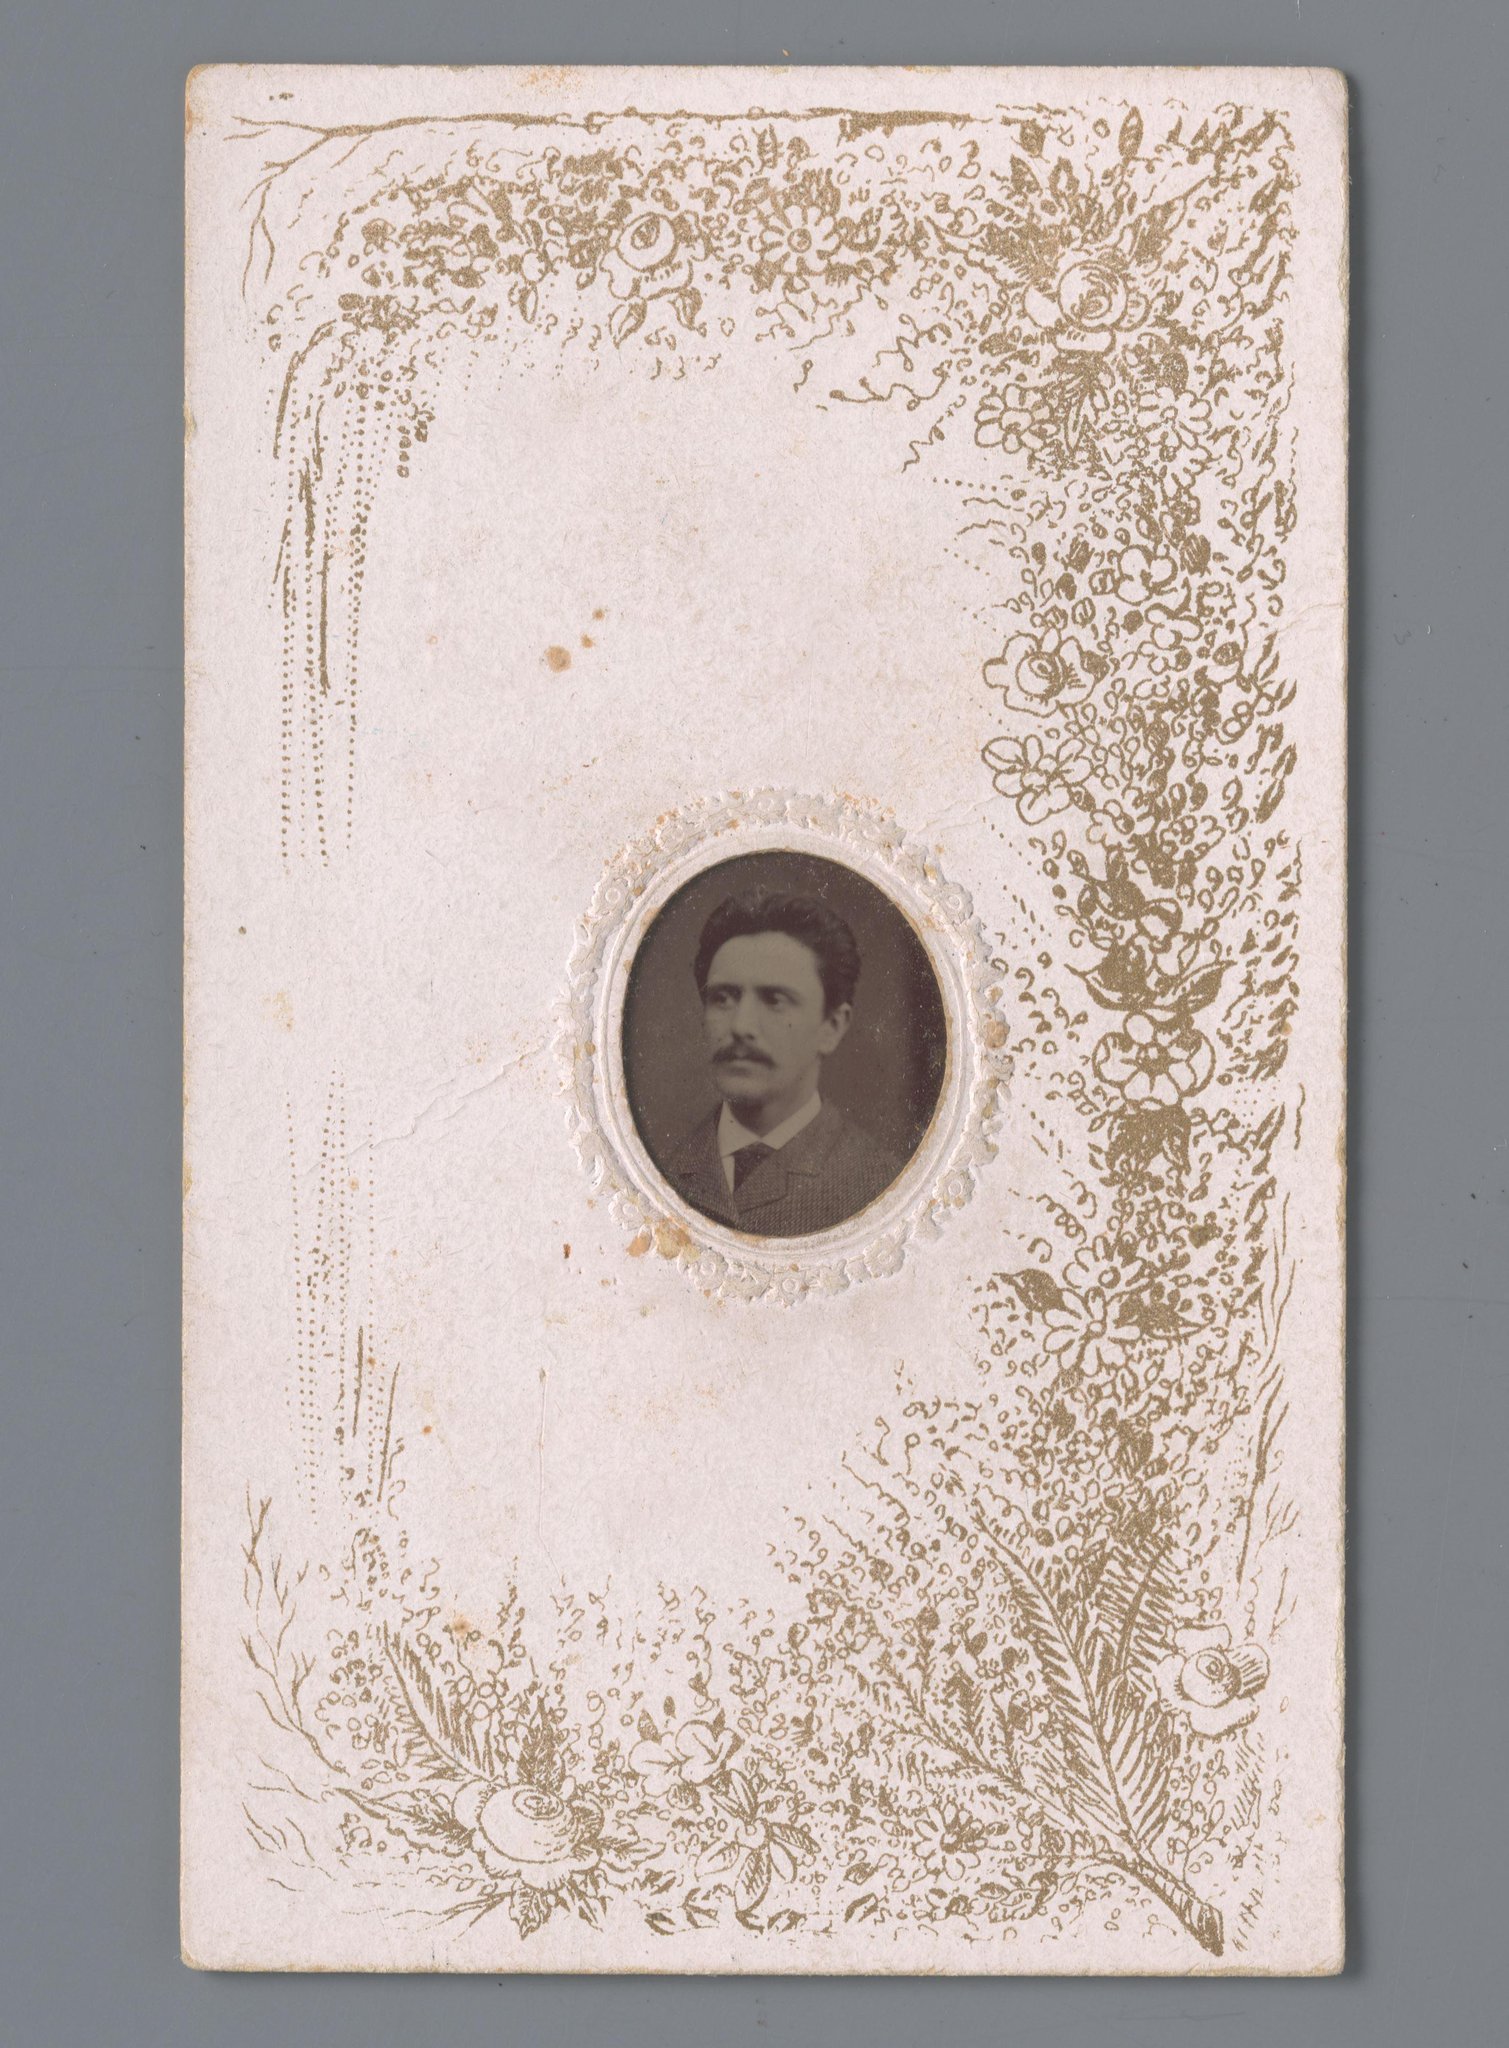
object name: photograph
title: Portret van een onbekende man met snor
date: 1855-1900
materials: cardboard, iron, paper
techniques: ferrotyping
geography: antwerp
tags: moustache, historical persons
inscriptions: inscription: ‘Phot. Américaine/ Rue Porte-aux-/ Vaches 22/ Anvers’